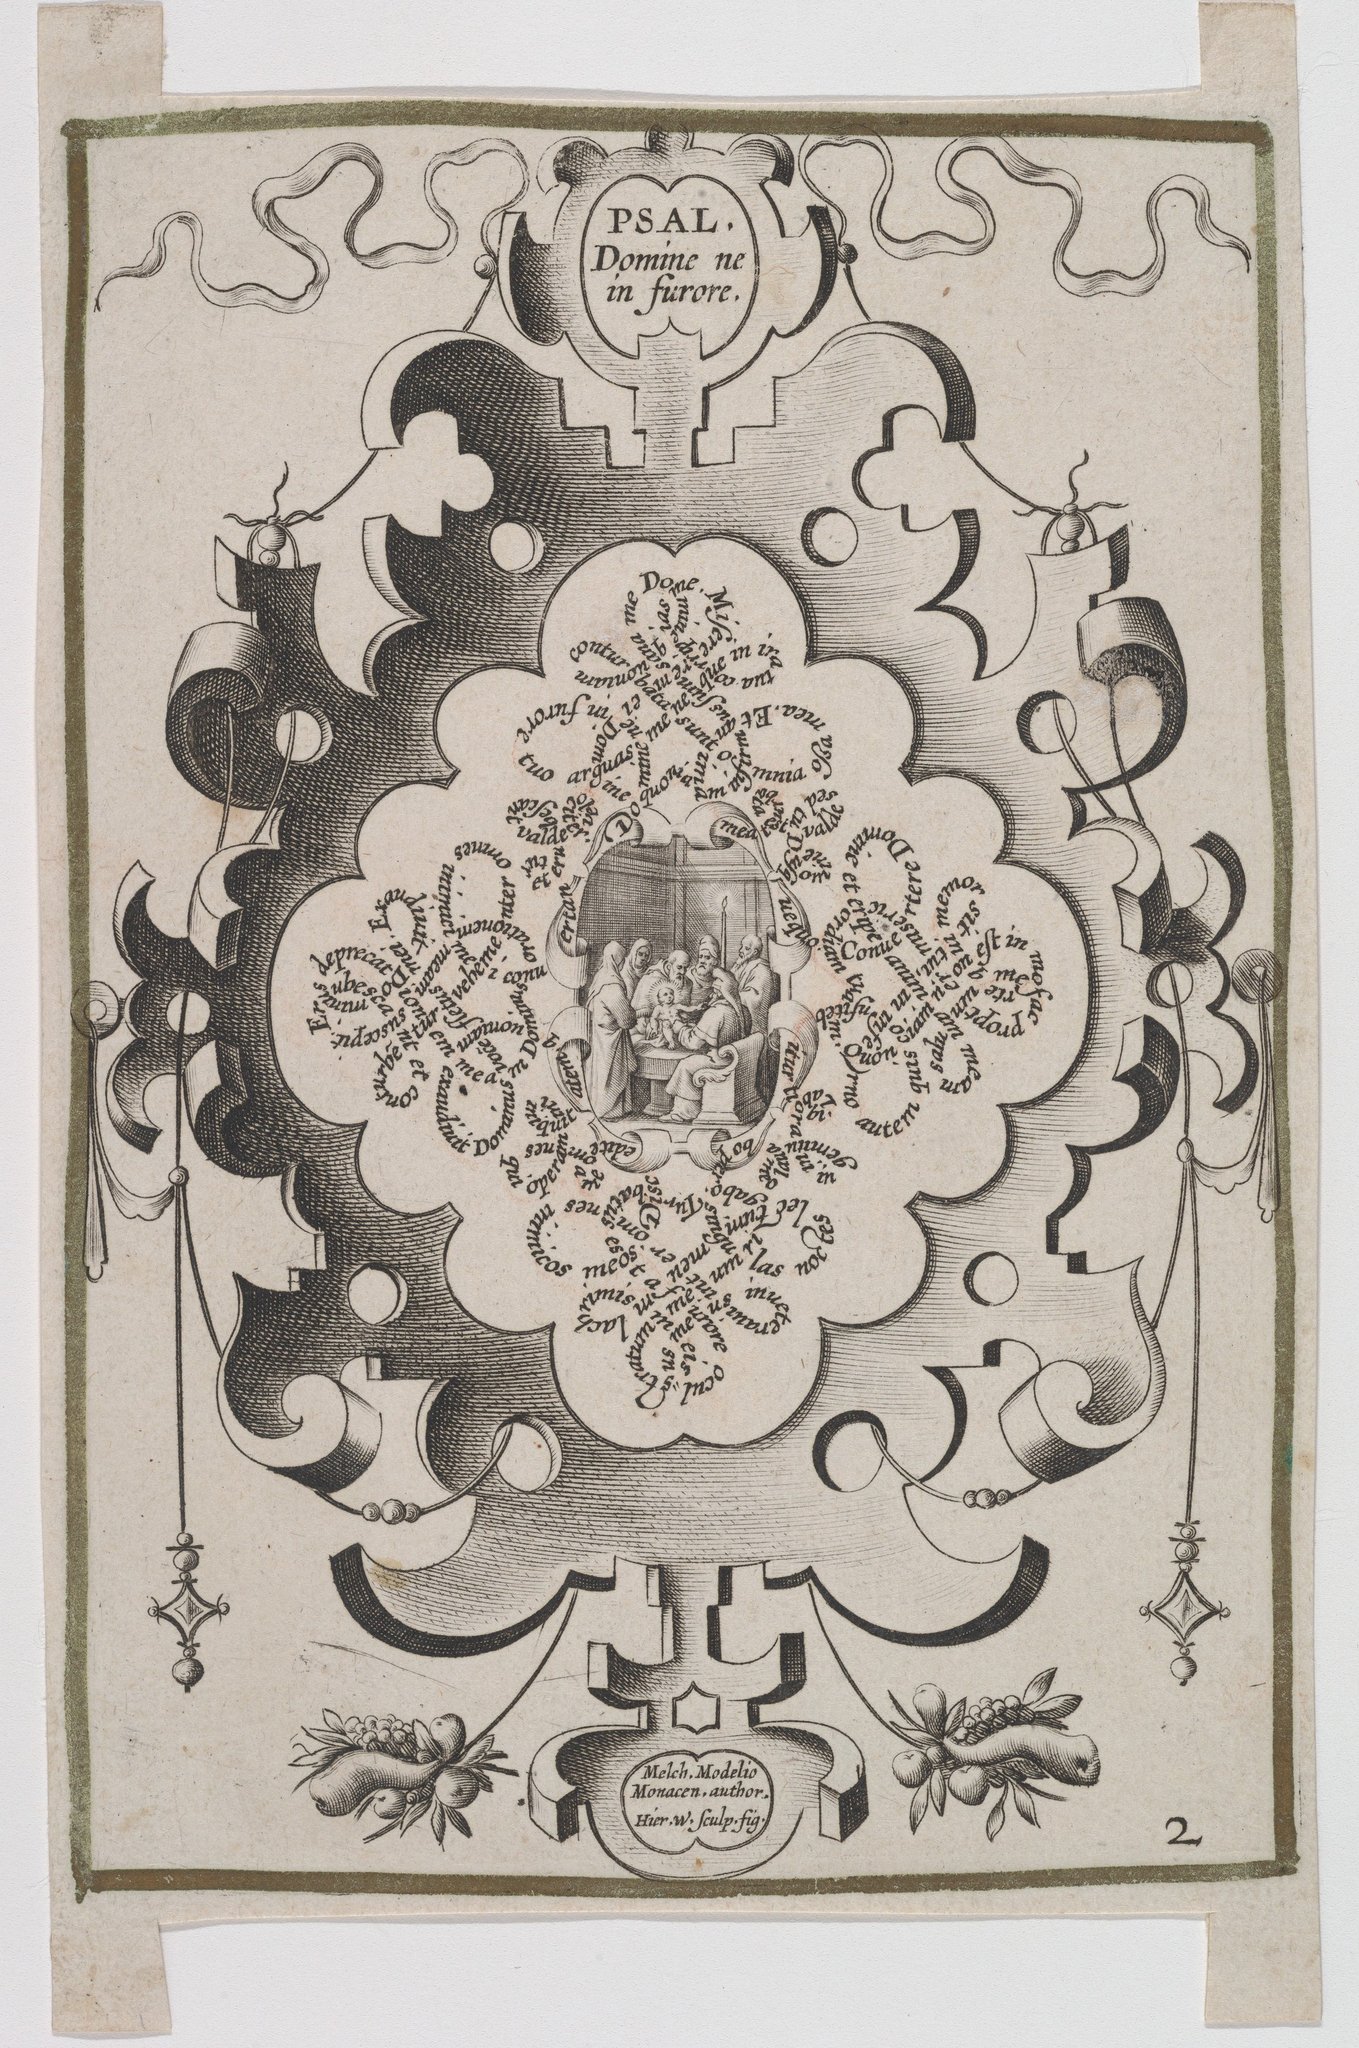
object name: album print ornament architecture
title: Titlepage, from "Septem Psalmi Davidici" (Seven Psalms of David)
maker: melchior model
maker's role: calligrapher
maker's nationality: german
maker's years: 1589-1608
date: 1608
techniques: coloring, engraving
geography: antwerp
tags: infants,men,women